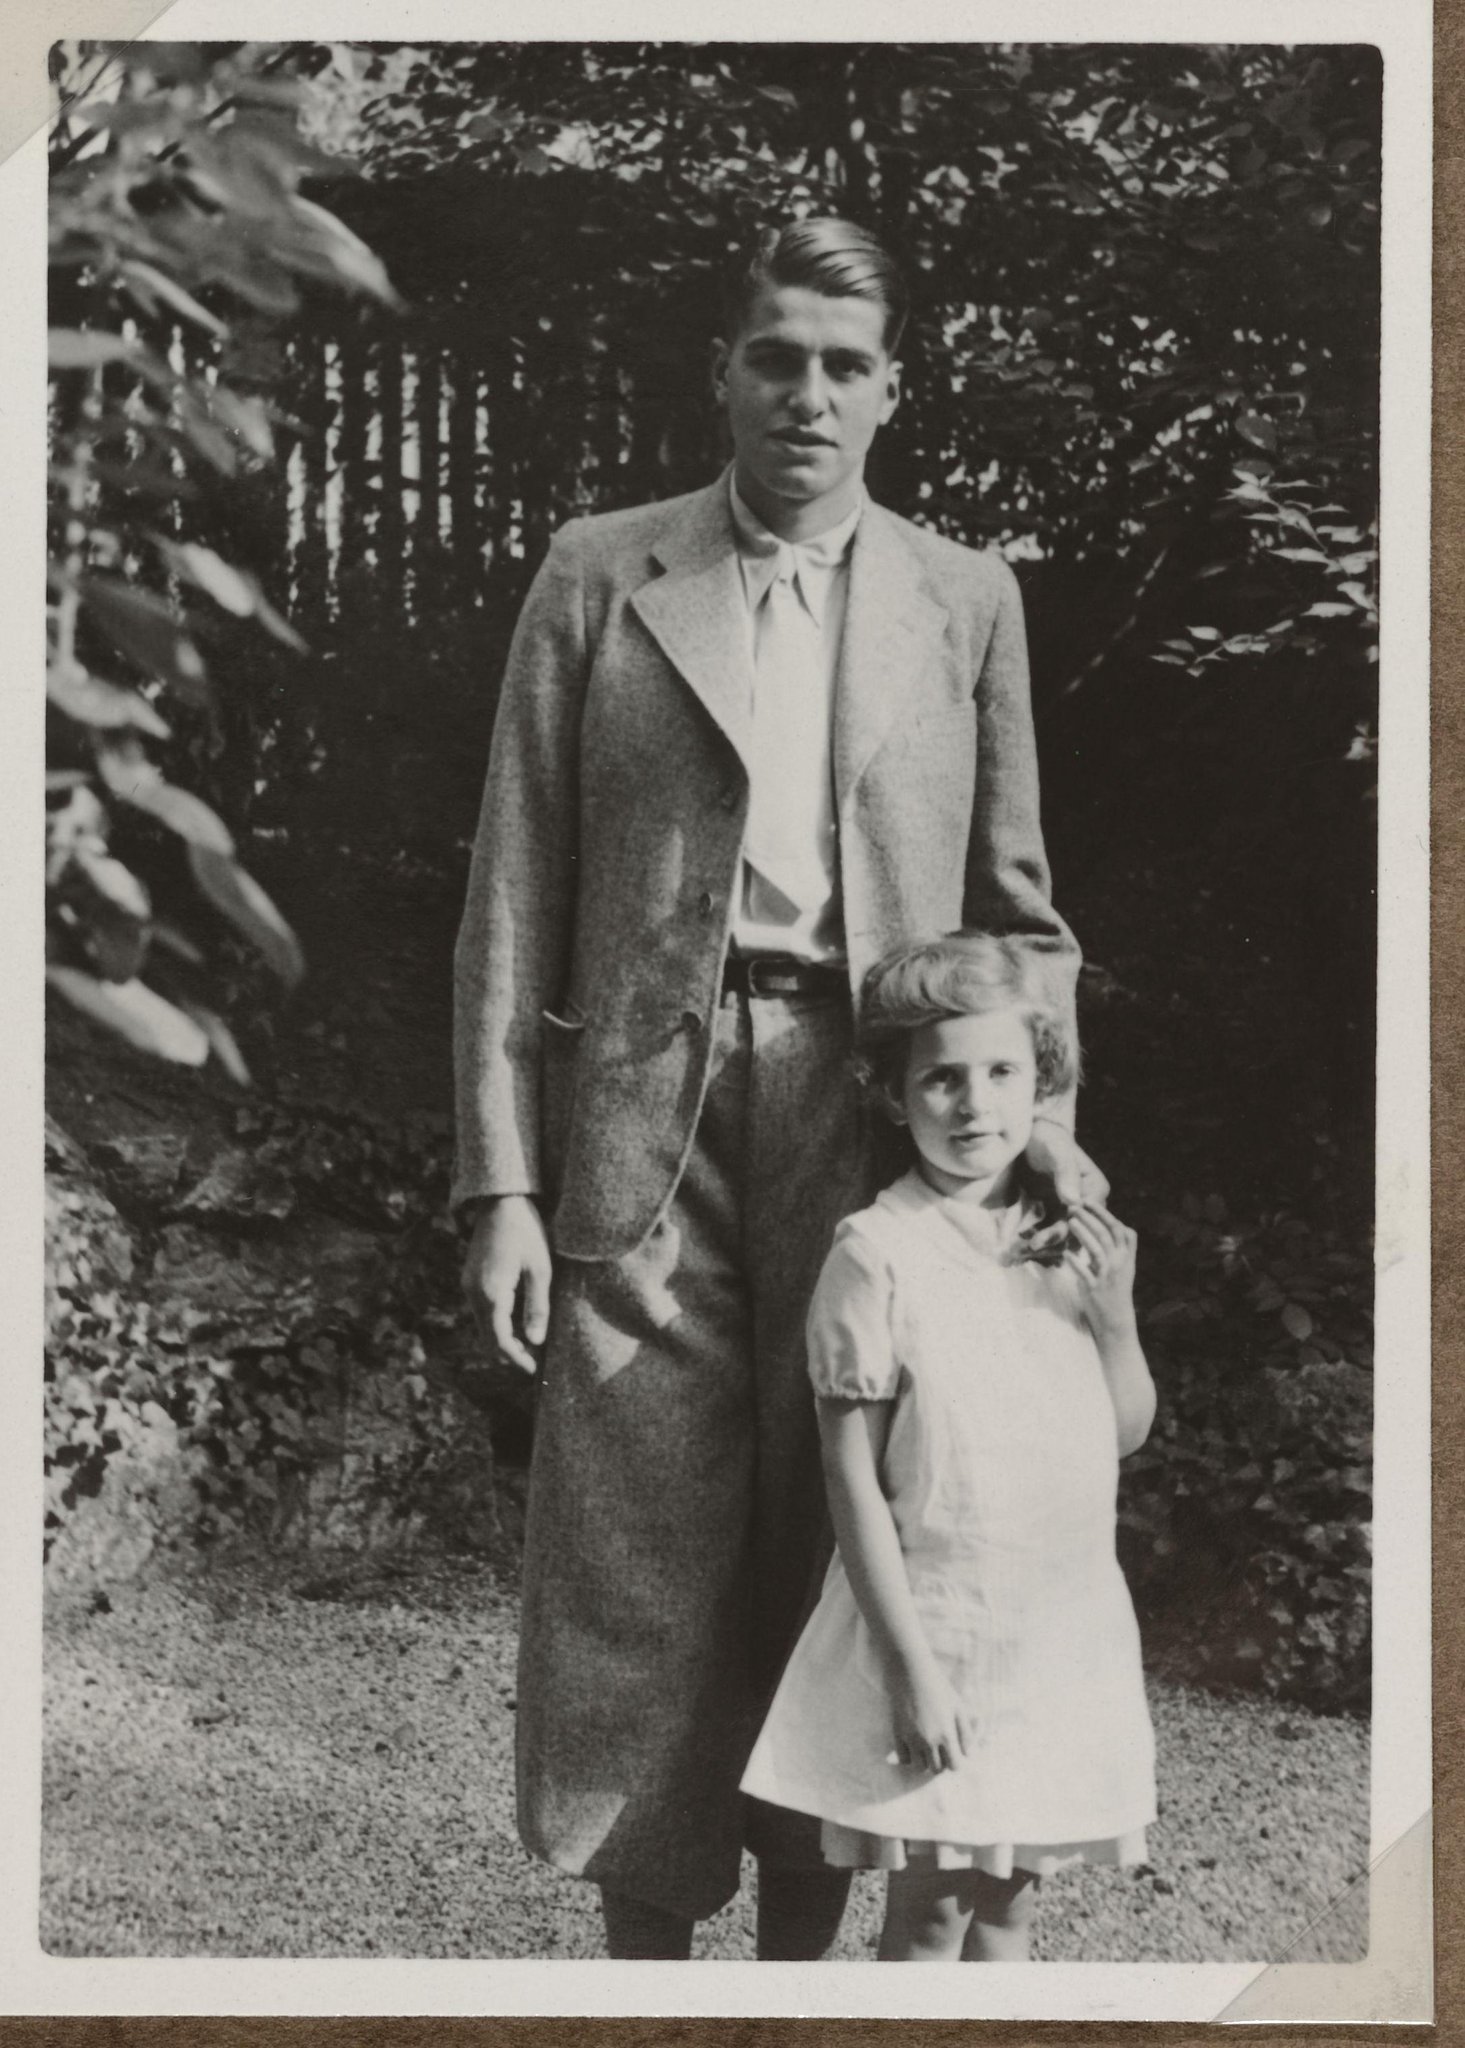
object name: photograph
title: Isabel Wachenheimer en haar neef Klaus Zürndorfer bij de ingang van de woning van de familie Wachenheimer in Stuttgart, augustus 1934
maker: Anonymous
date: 1908-1934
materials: photographic support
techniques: gelatin silver print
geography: stuttgart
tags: leiden, isabel wachenheimer-elon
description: Dit object is onderdeel van de nalatenschap van Isabel Elon-Wachenheimer (1928-2010). Tot haar overlijden behoorde het samen met de andere objecten uit de nalatenschap tot haar privédomein van Isabel Wachenheimer. In die particuliere context zijn deze objecten tezamen en individueel aandenkens - aan de jeugd, ouders en familie van Isabel Wachenheimer vóór en tijdens de Shoah en aan haar leven na de Tweede Wereldoorlog. Isabel Wachenheimer, die van juni 1943 tot mei 1945 gevangen zat in Kamp Westerbork, Theresienstadt, Auschwitz, Lenzing a/d Oberdonau (een buitenkamp van Mauthausen), overleefde de Shoah. Haar ouders – Eugène Wachenheimer en Else Wachenheimer-Moos - werden op 14 oktober 1944 in Auschwitz-Birkenau vermoord.